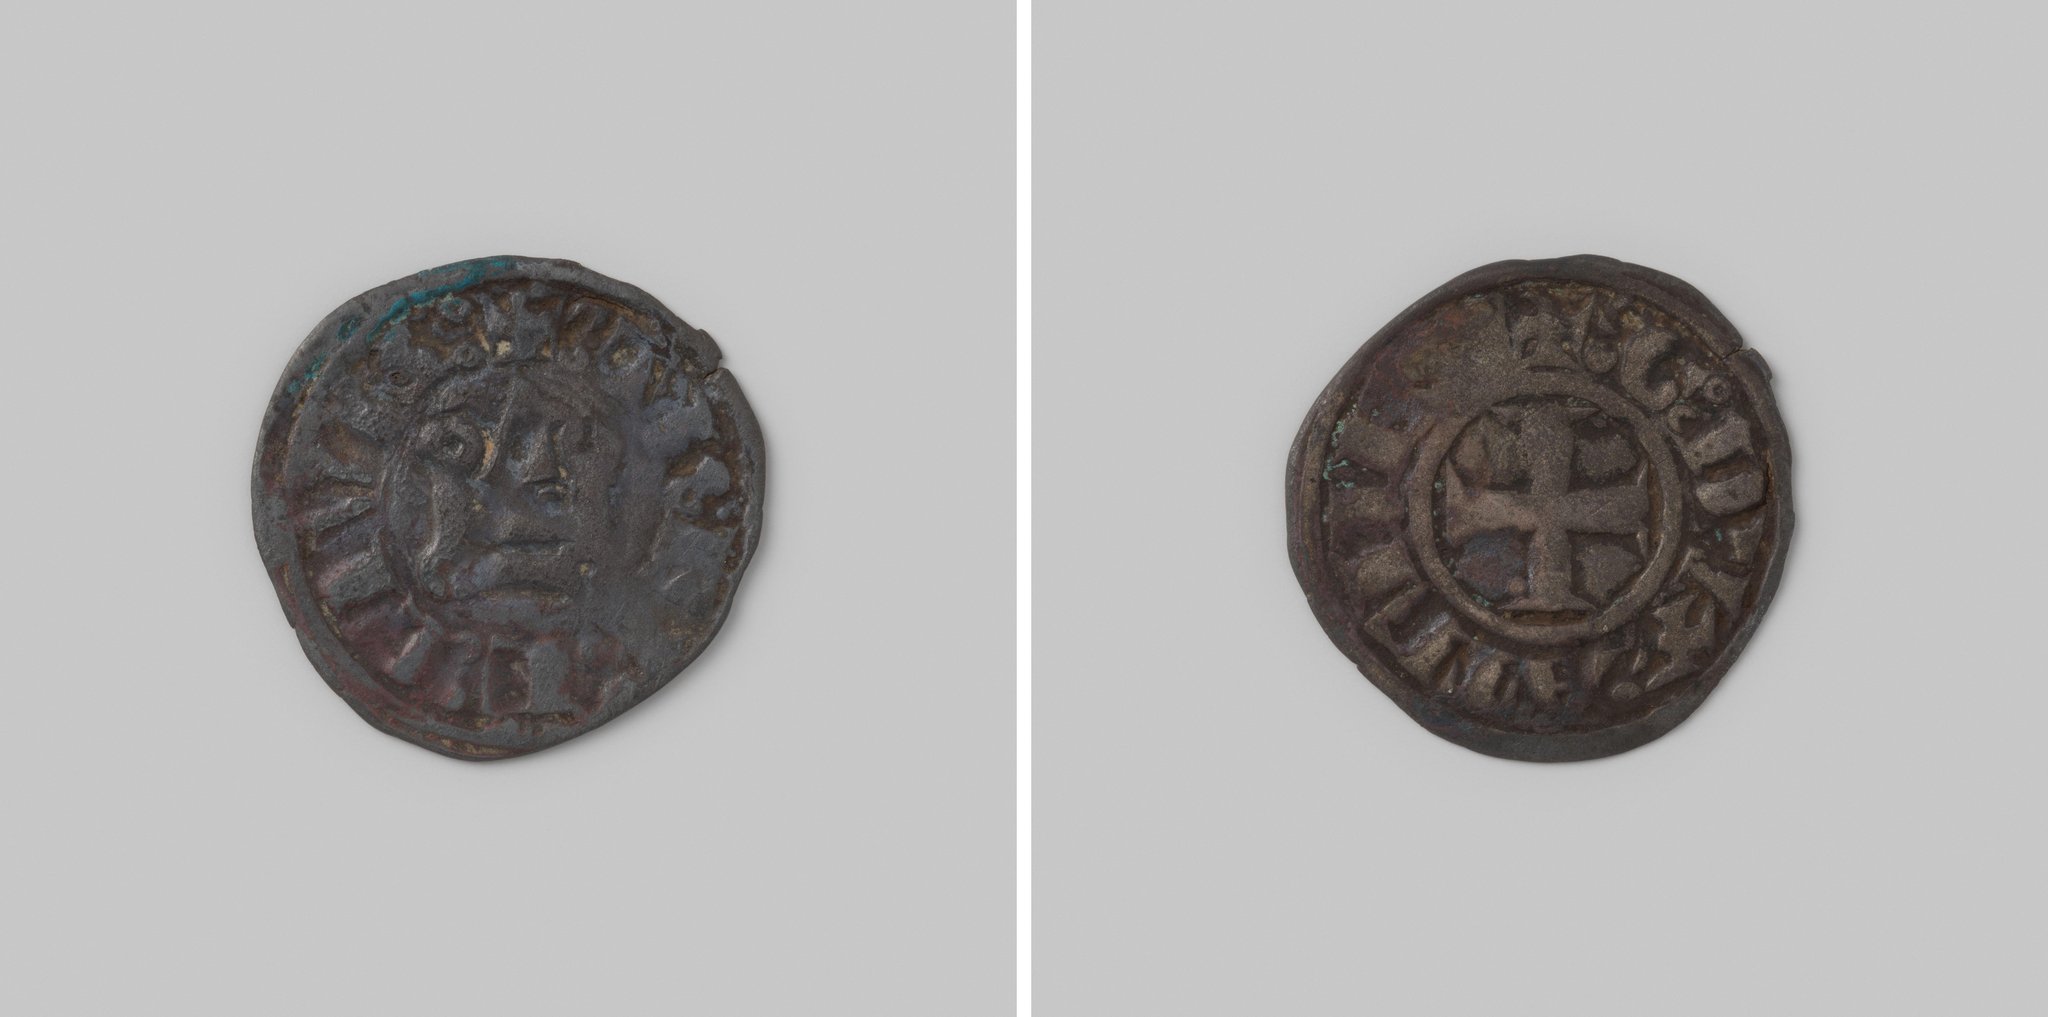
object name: coin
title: Hertogdom Athene, tourse penning, Guillaume I,1280-1287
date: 1280-1287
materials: silver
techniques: striking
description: Zilveren munt. Voorzijde: kasteel met drie torens. Boven middelste, spitse toren kruis als begin van het omschrift. Keerzijde: kort gevoet kruis. Geslagen in Thebe.